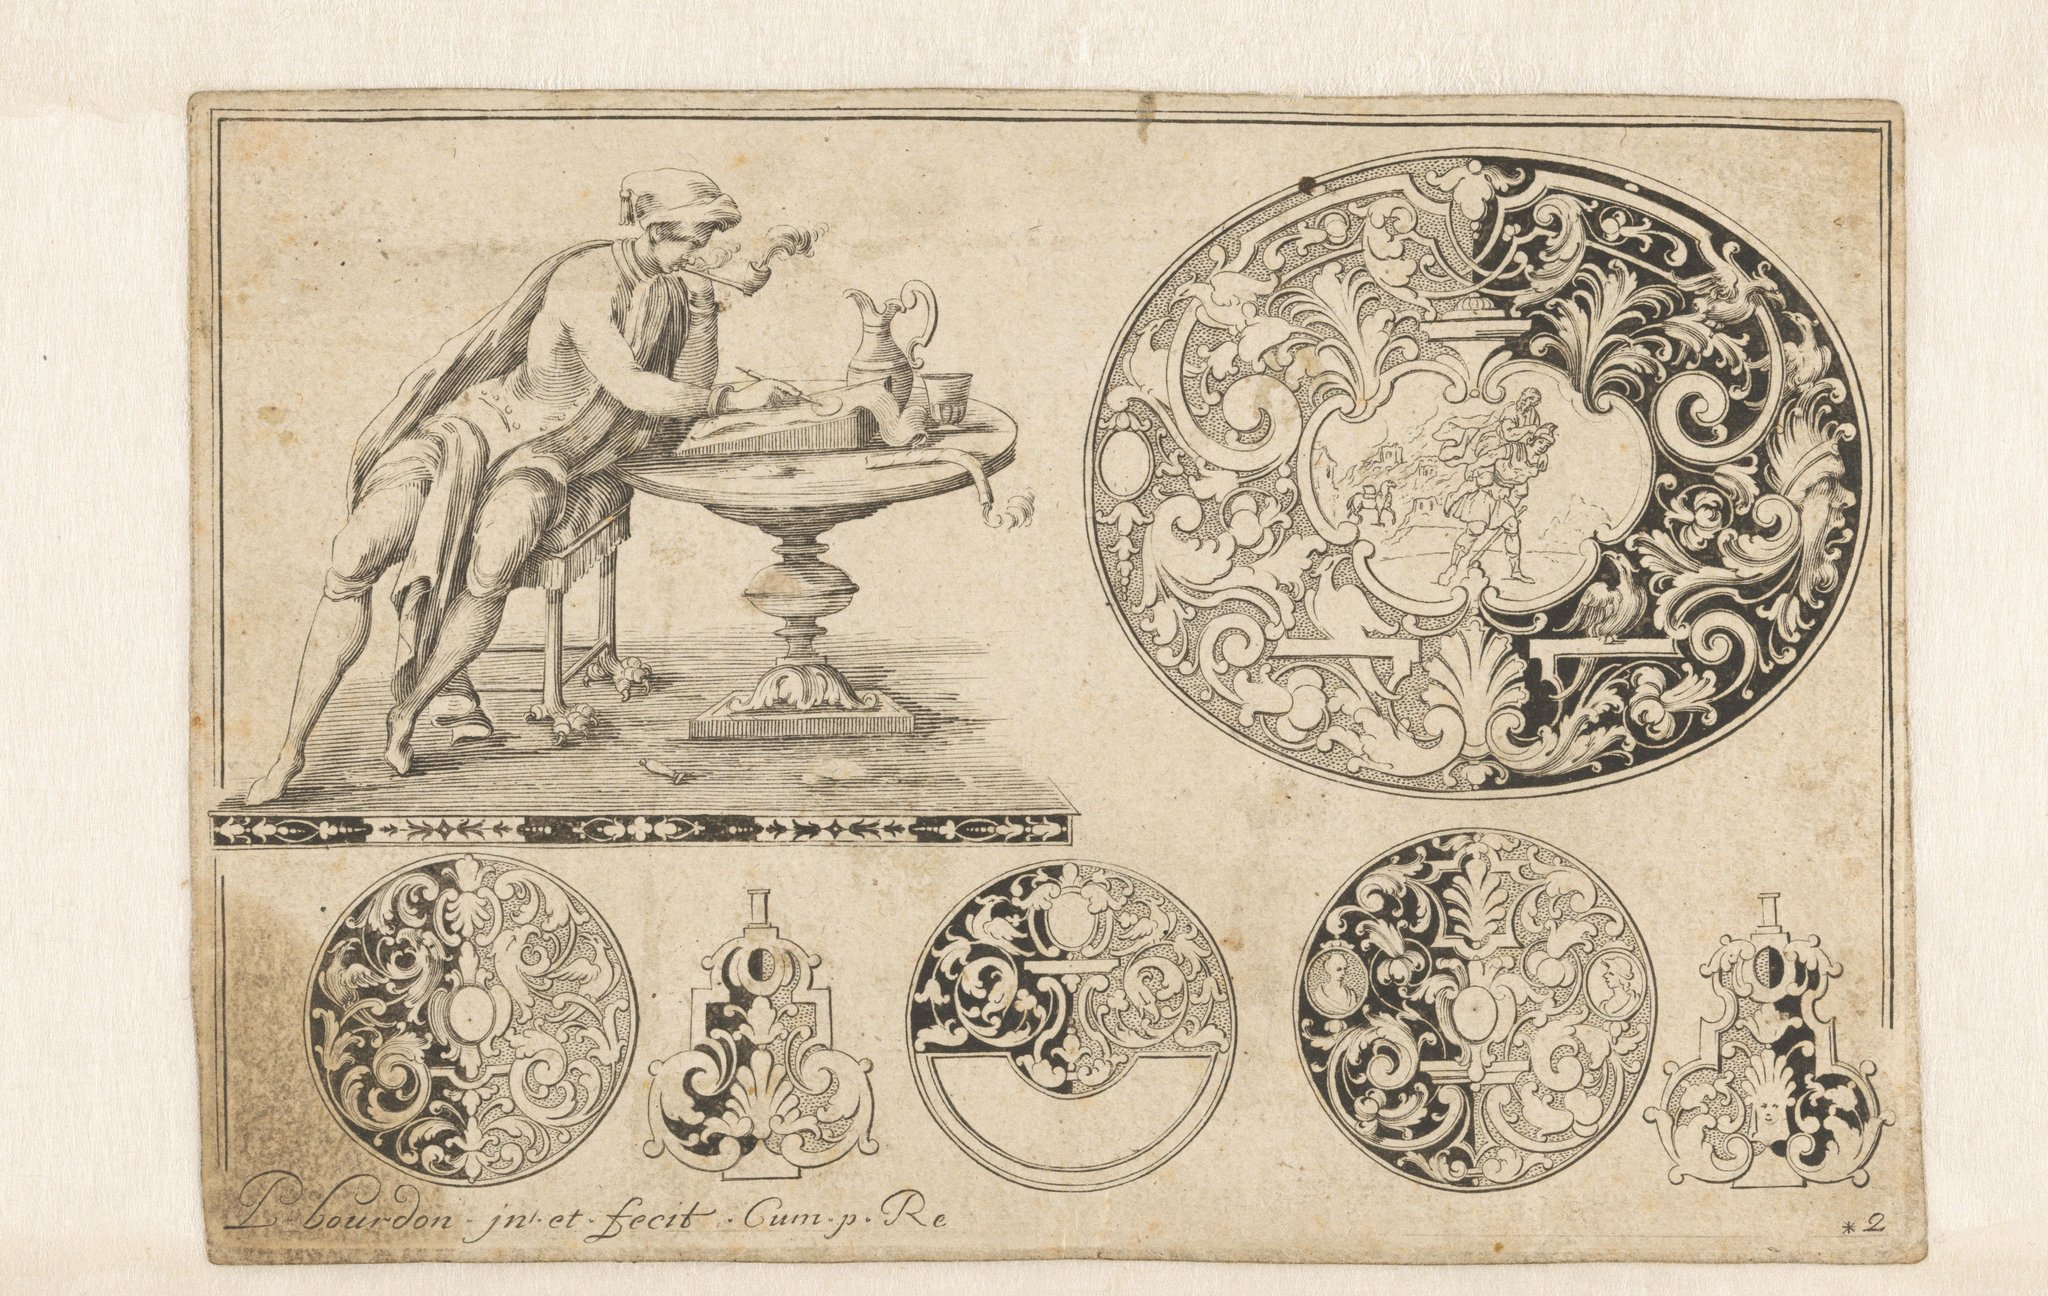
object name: print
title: Livre Second: Essais de gravure par Pierre Bourdon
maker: pierre bourdon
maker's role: print maker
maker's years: 1656-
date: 1703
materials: paper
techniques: engraving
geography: paris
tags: ornaments ~ art, pipe ~ tobacco, watch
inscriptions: collector's mark, privilege: ‘Cum p. Re’, signature: ‘P. bourdon in et fecit’, number: ‘*2’, collector's mark: Lugt 2228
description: Blad uit serie van zeven van ontwerpen voor horlogemakers, goudsmeden, beeldhouwers en graveurs. Ontwerpen rondom een centrale scène van een pijprokende man, zittend op een stoel aan een tafel.